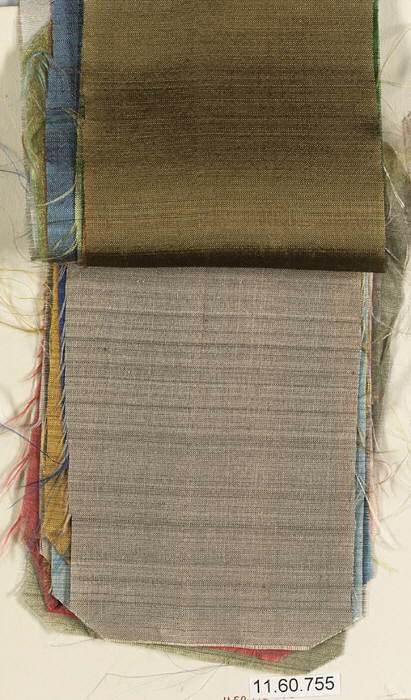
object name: sample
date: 1801-1833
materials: silk